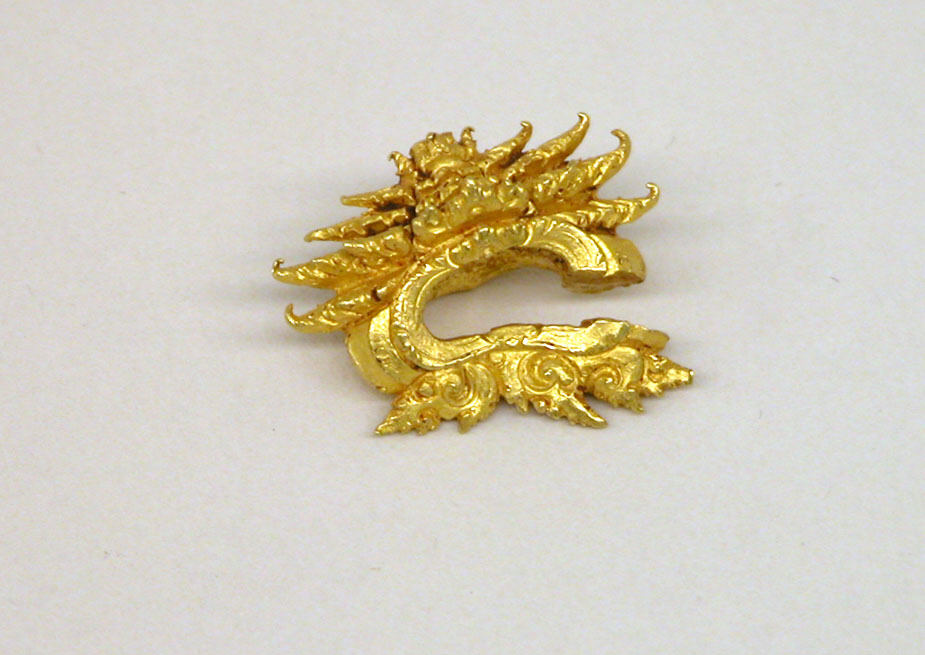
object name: ear ornament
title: Ear Ornament with Lozenge-Shaped Motif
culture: indonesian, javanese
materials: gold